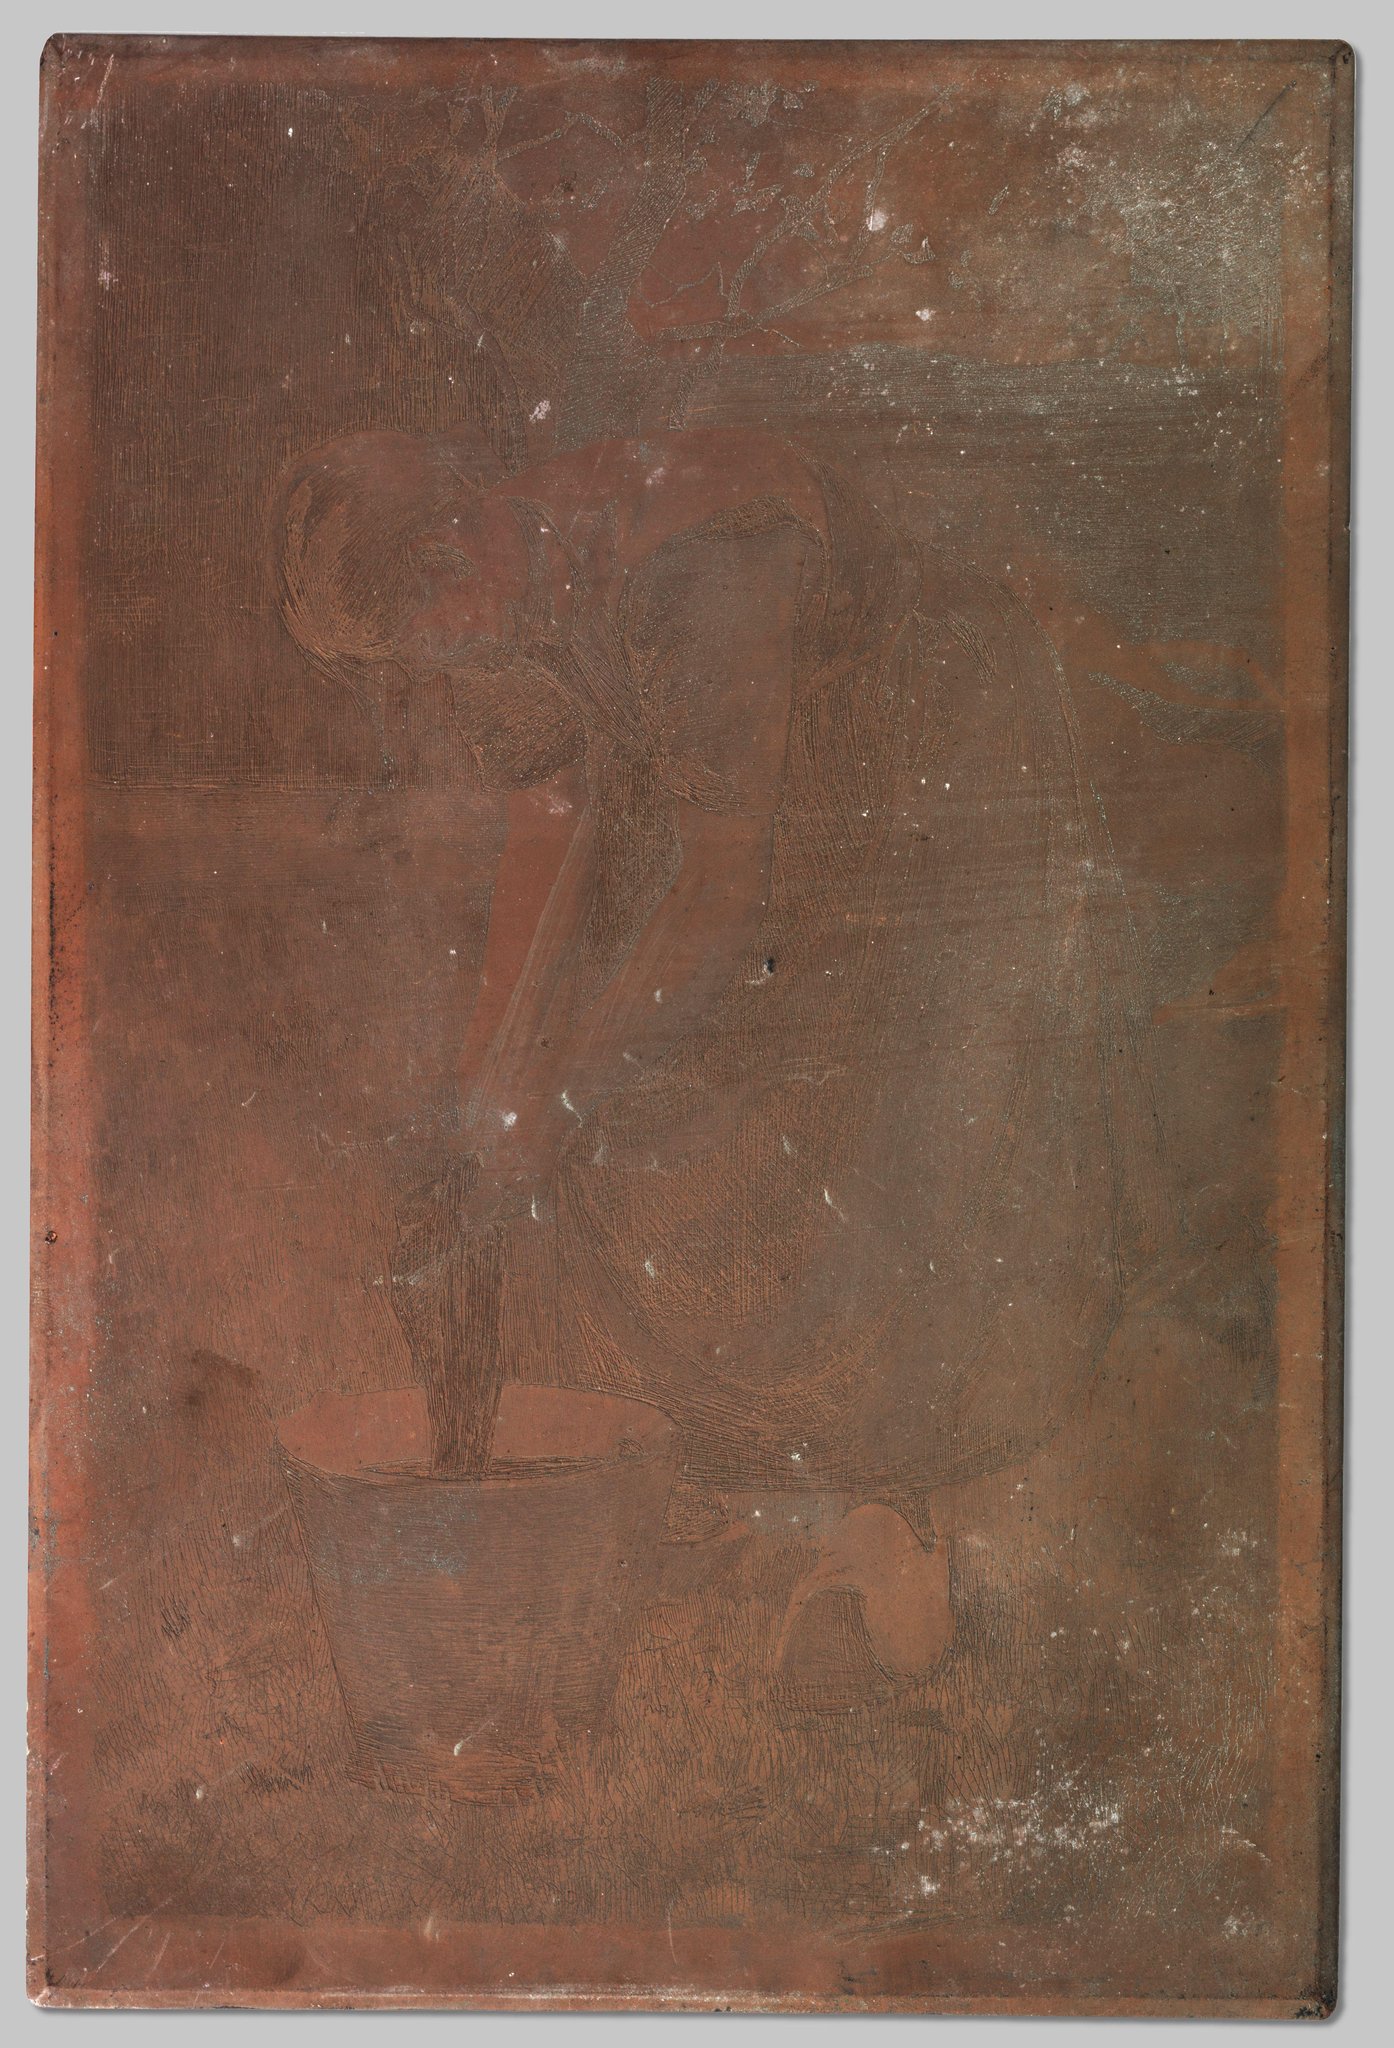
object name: copper plate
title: Staande vrouw bij wasemmer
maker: willem witsen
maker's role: draughtsman, painter, print maker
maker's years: 1860-1923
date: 1886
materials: copper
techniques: etching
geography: ewijkshoeve